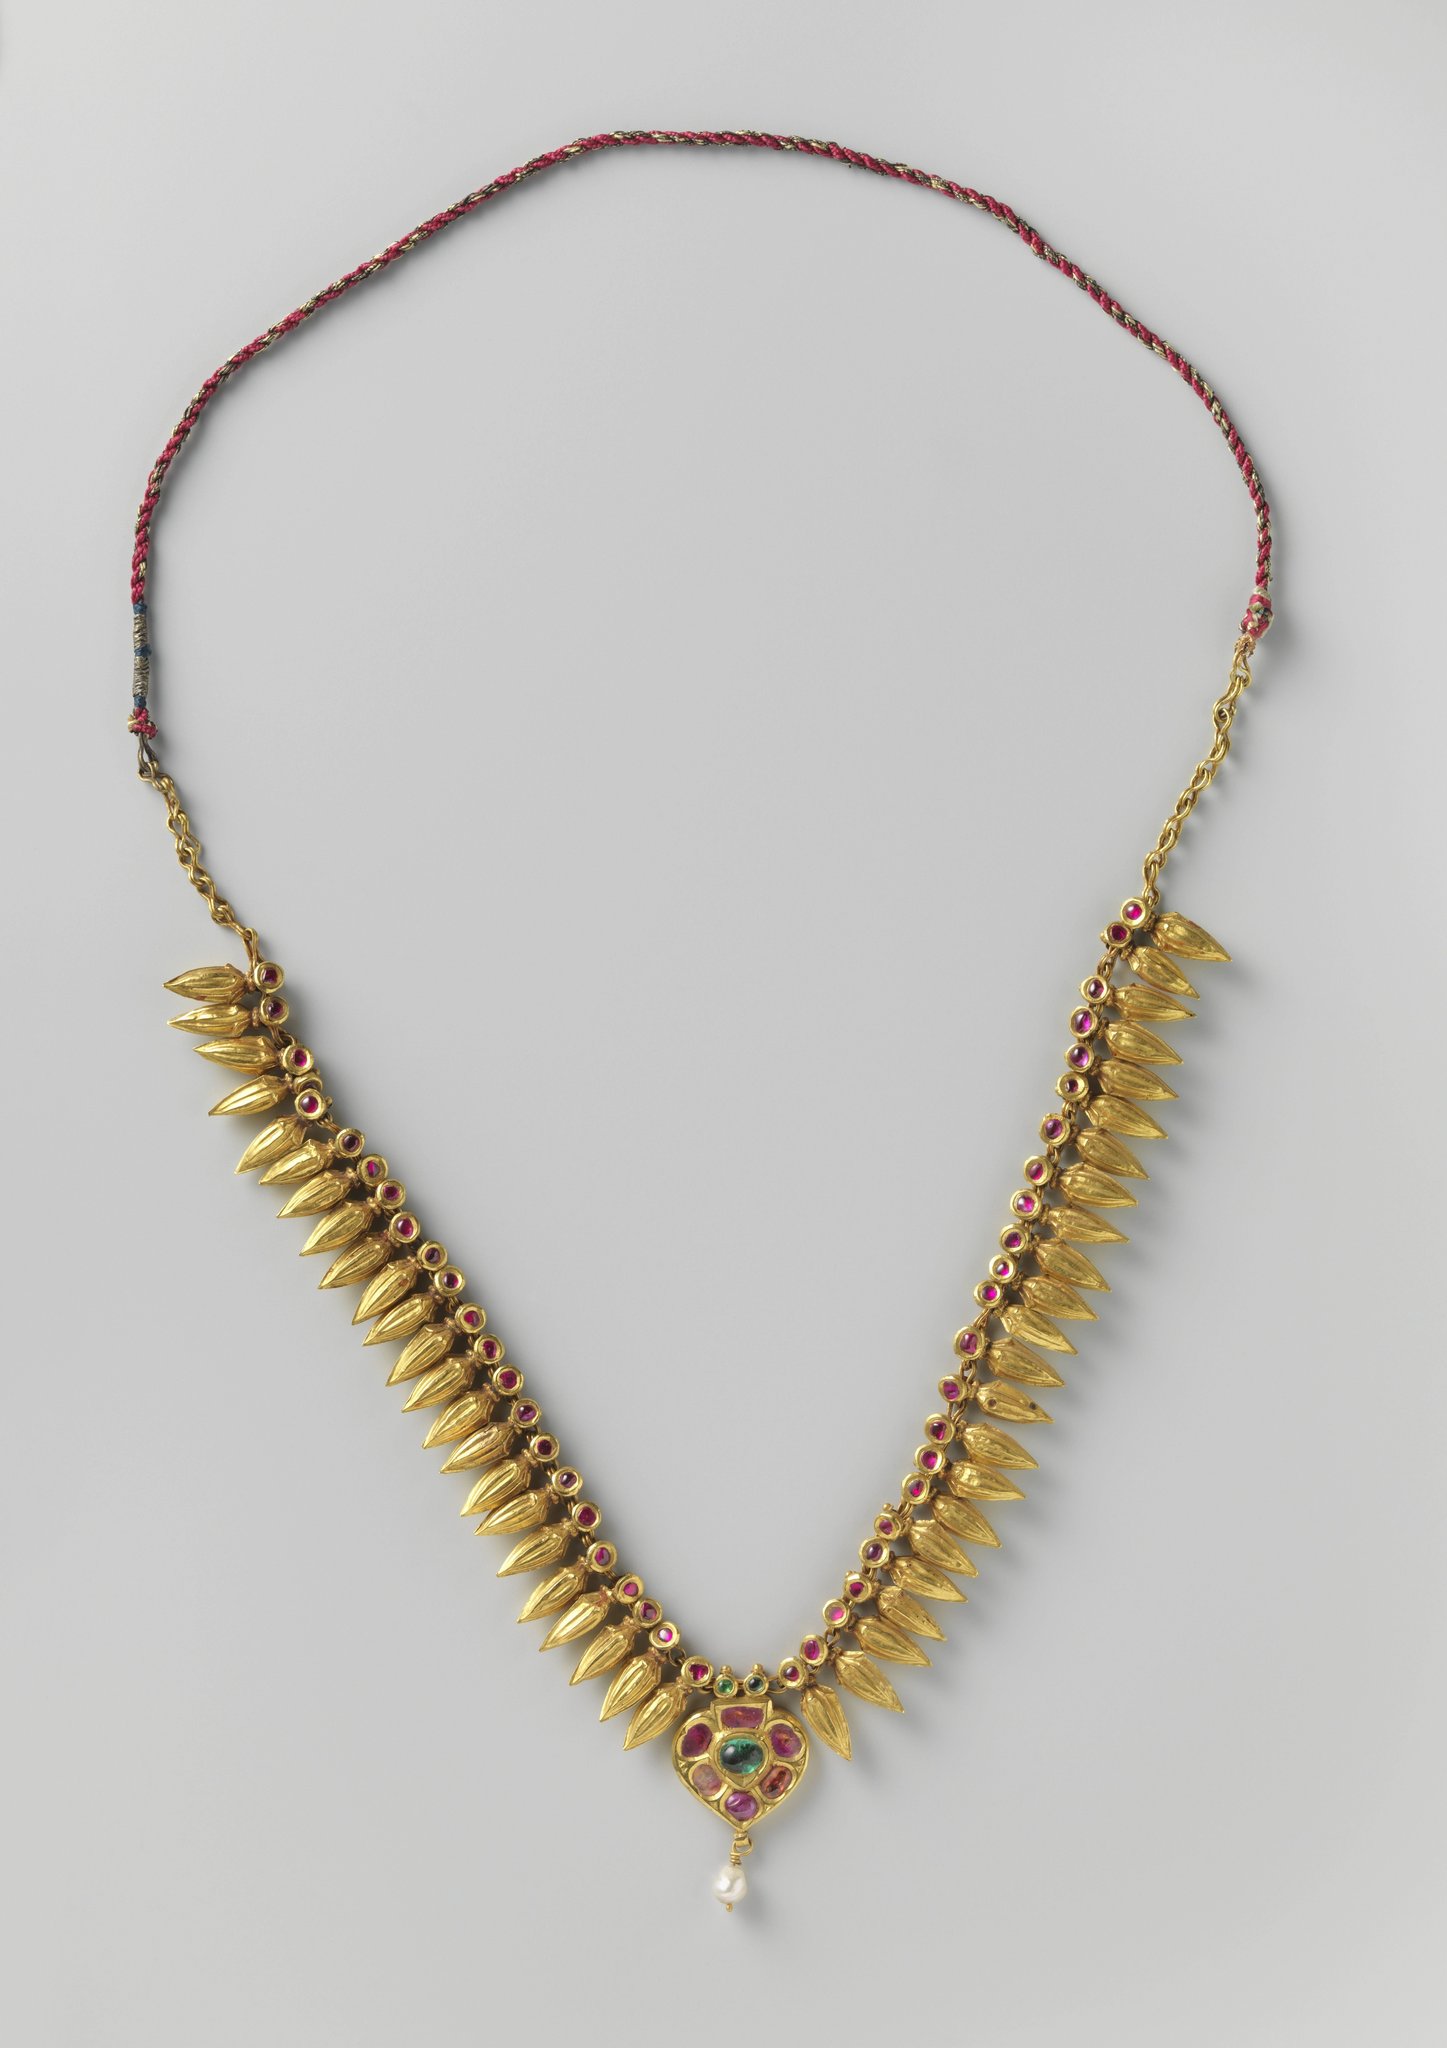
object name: champakali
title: Necklace (champakali)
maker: Anonymous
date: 1750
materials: gold, pearl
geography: surat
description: Een halsketen (champakali) van goud. In het midden een hartvormige hanger, ingelegd met rode en groene steentjes, waaraan een parel hangt. De ketting bestaat uit gouden kralen in de vorm van een gouden oog met een ingelegd rood steentje, waaraan een gouden gerstekorrel hangt.